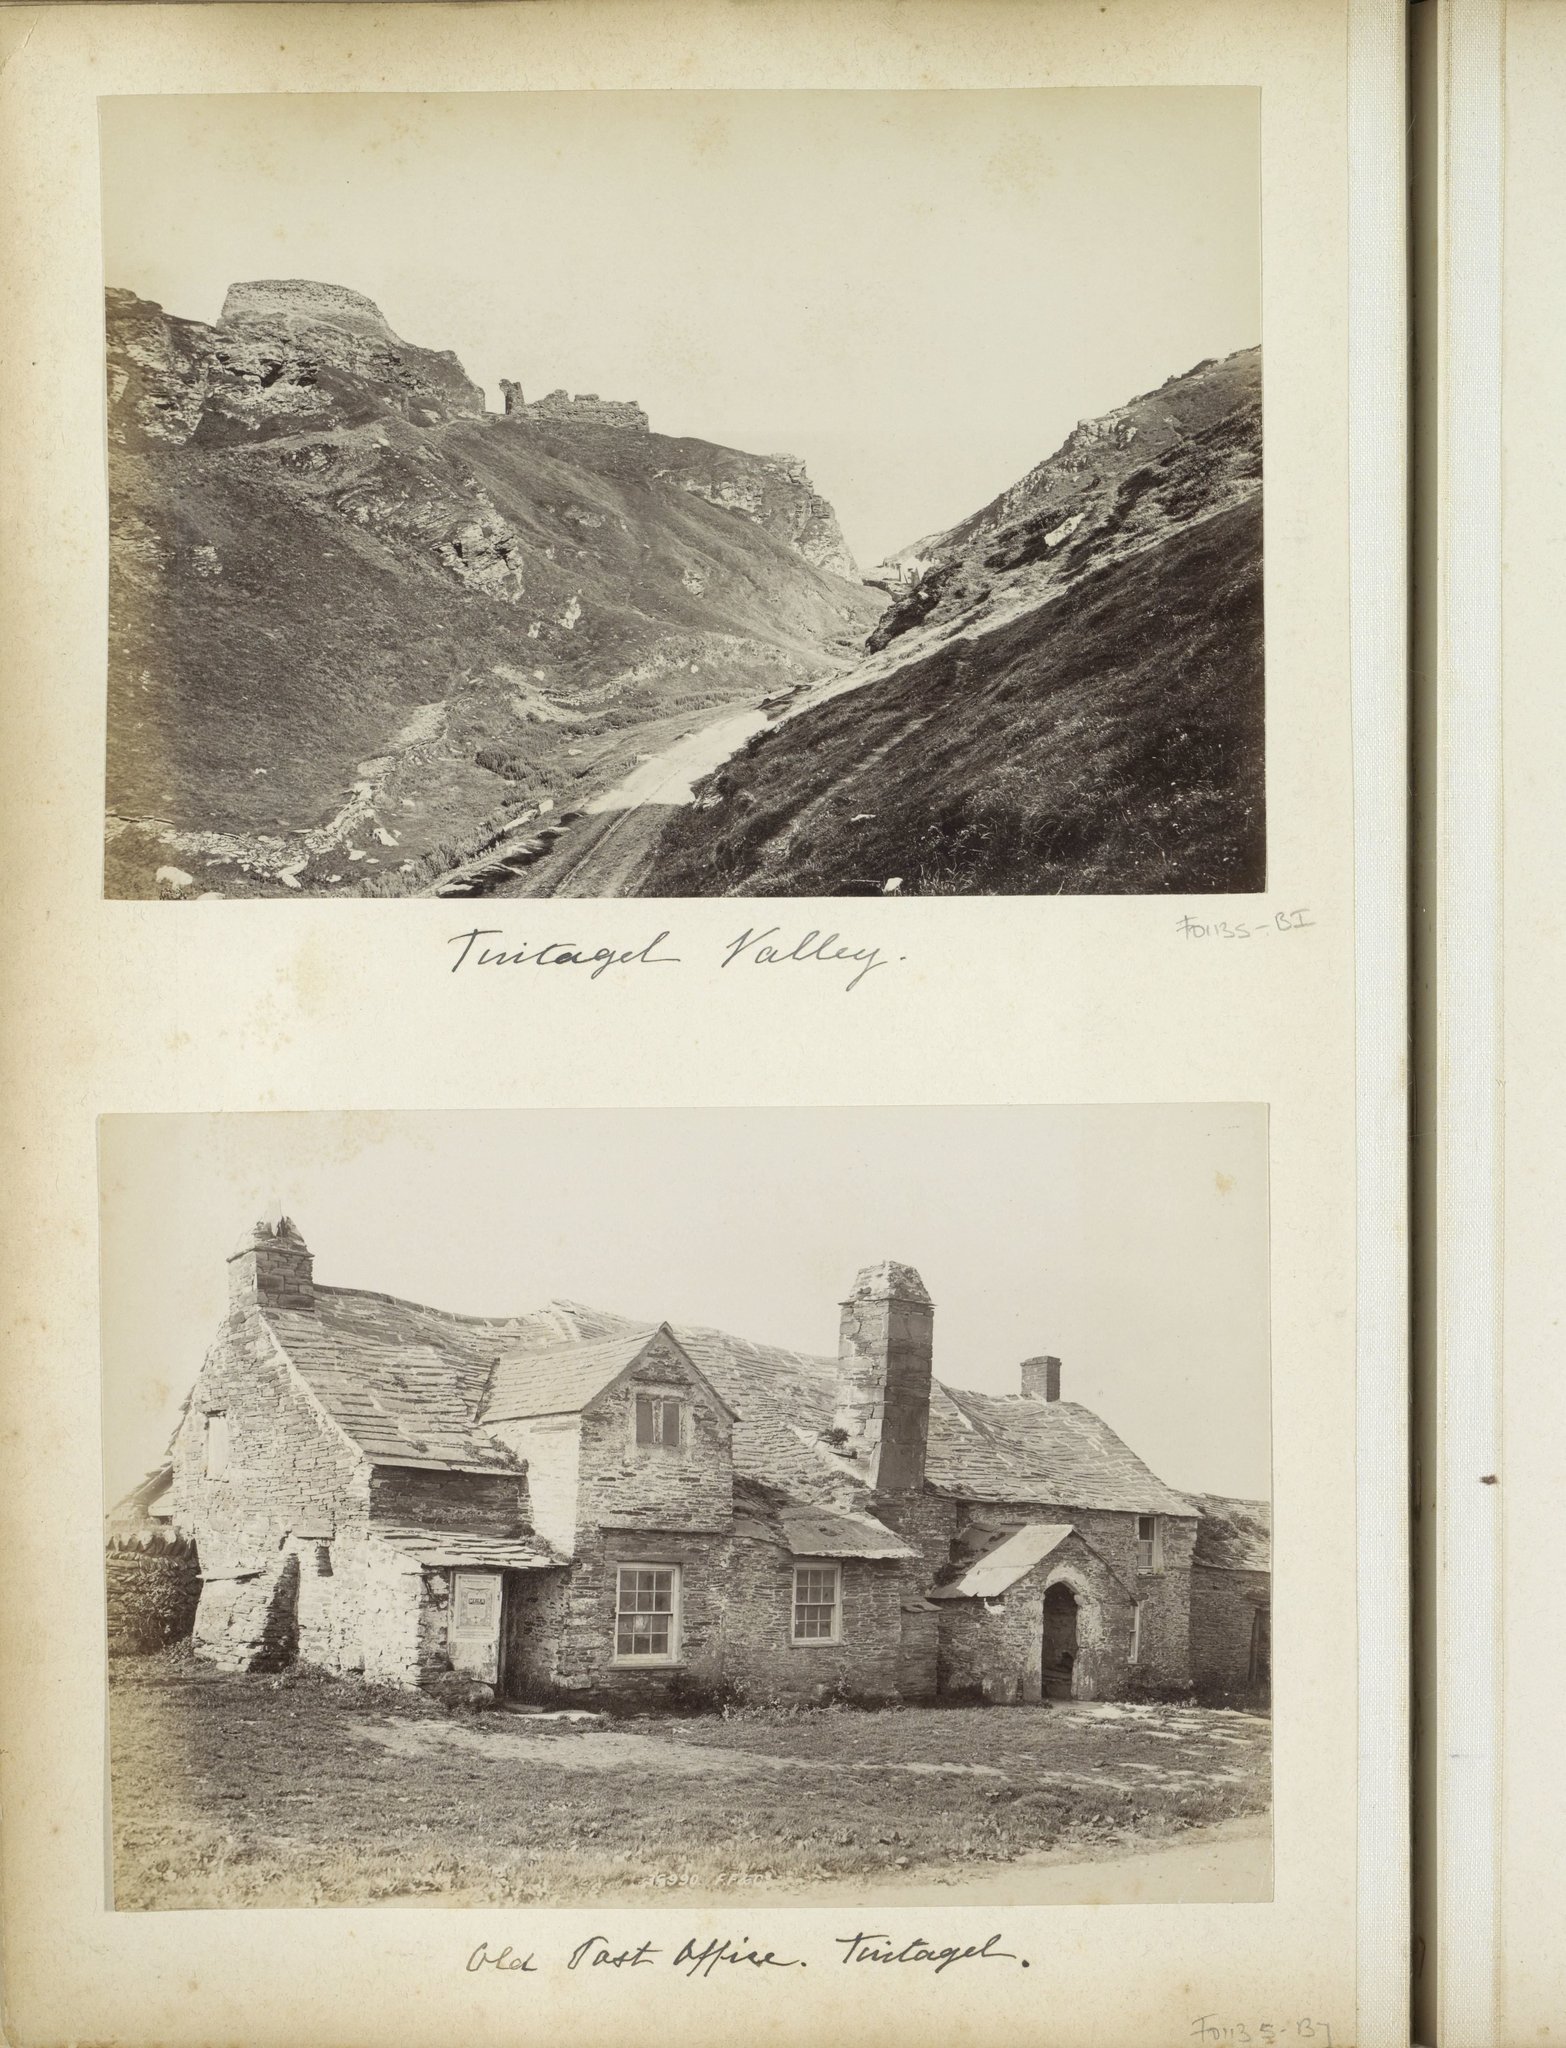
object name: album leaf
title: Exterieur van het oude postkantoor van Tintagel met op een deur het opschrift 'Meier Family'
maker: Anonymous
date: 1899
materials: paper, photographic support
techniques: albumen print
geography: tintagel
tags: post-office, rural housing, e.g. country-house, villa, cottage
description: Onderdeel van Reisalbum met foto's van bezienswaardigheden in Engeland en Frankrijk.